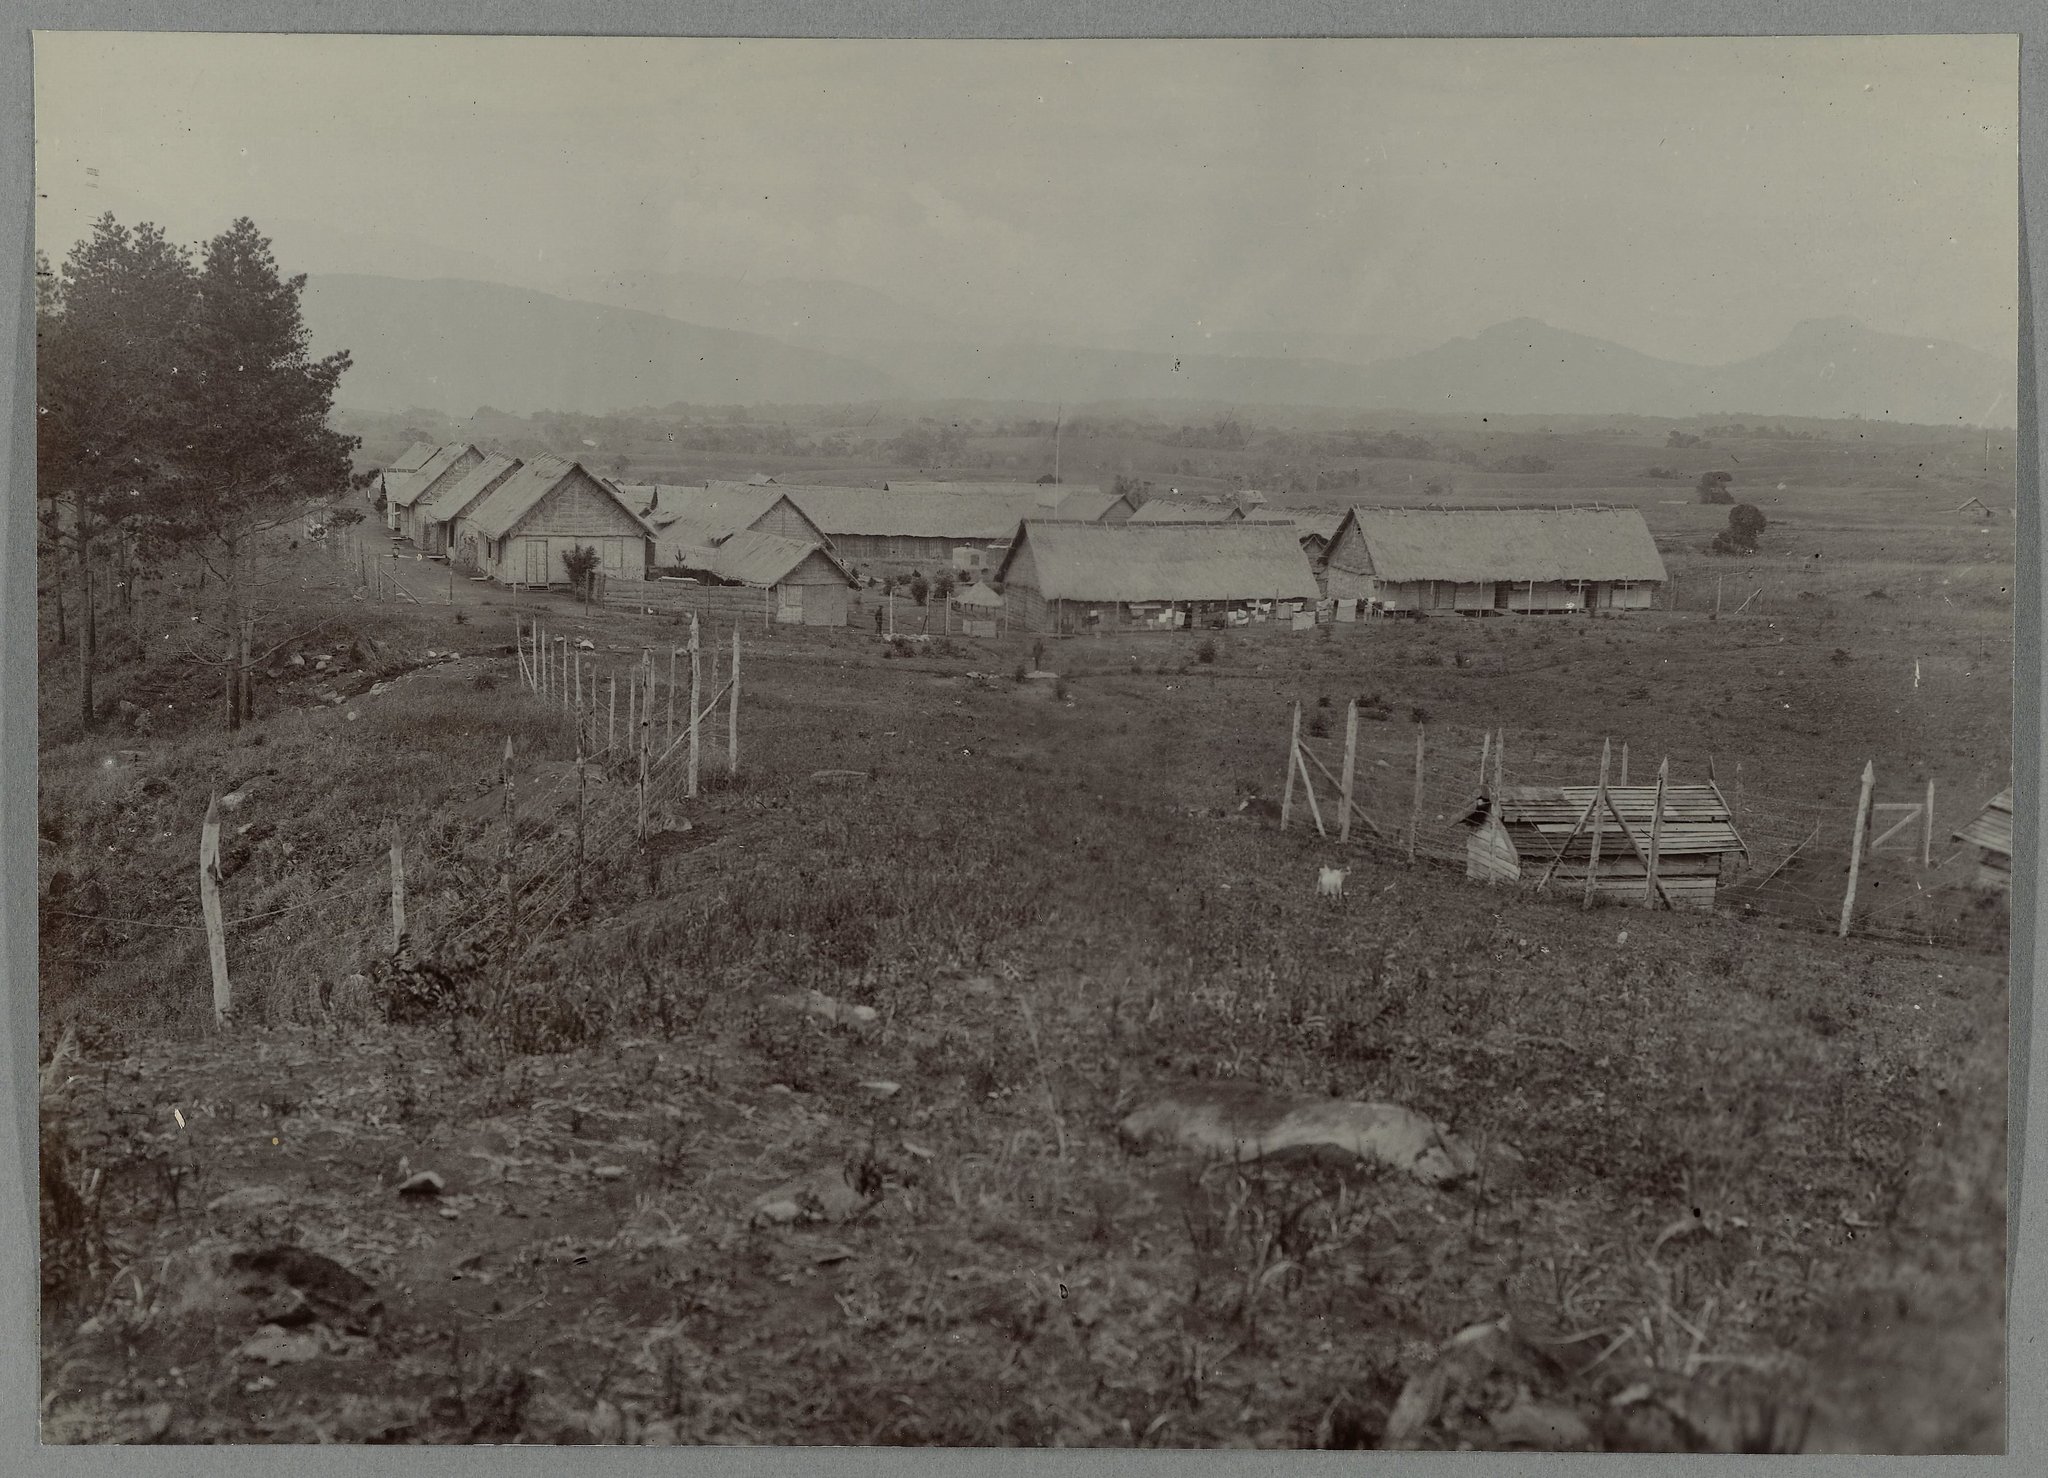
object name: photograph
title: Oud bivak te Blangrakal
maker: Anonymous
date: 1903-1913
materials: photographic support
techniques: photography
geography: north sumatra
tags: arnhem, the hague, albertus dominicus laman trip, traffic by road or path with motor-vehicle, landscapes in tropical and sub-tropical regions, village, road, path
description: Na de expedities naar de Gajo- en Alaslanden o.l.v. Van Daalen (eerste tocht in 1901), werd hij in 1903 belast met voorbereiding van permanente vestiging van Nederlands gezag. Aanleg van een weg van de Noordkust naar het binnenland was hierbij van groot belang. Deze zgn. Gajoweg werd aangelegd tussen 1903 en 1914, van Bireuen aan de kust naar Takinguen aan het bergmeer Danau Lauttawar, totale lente 104 km.